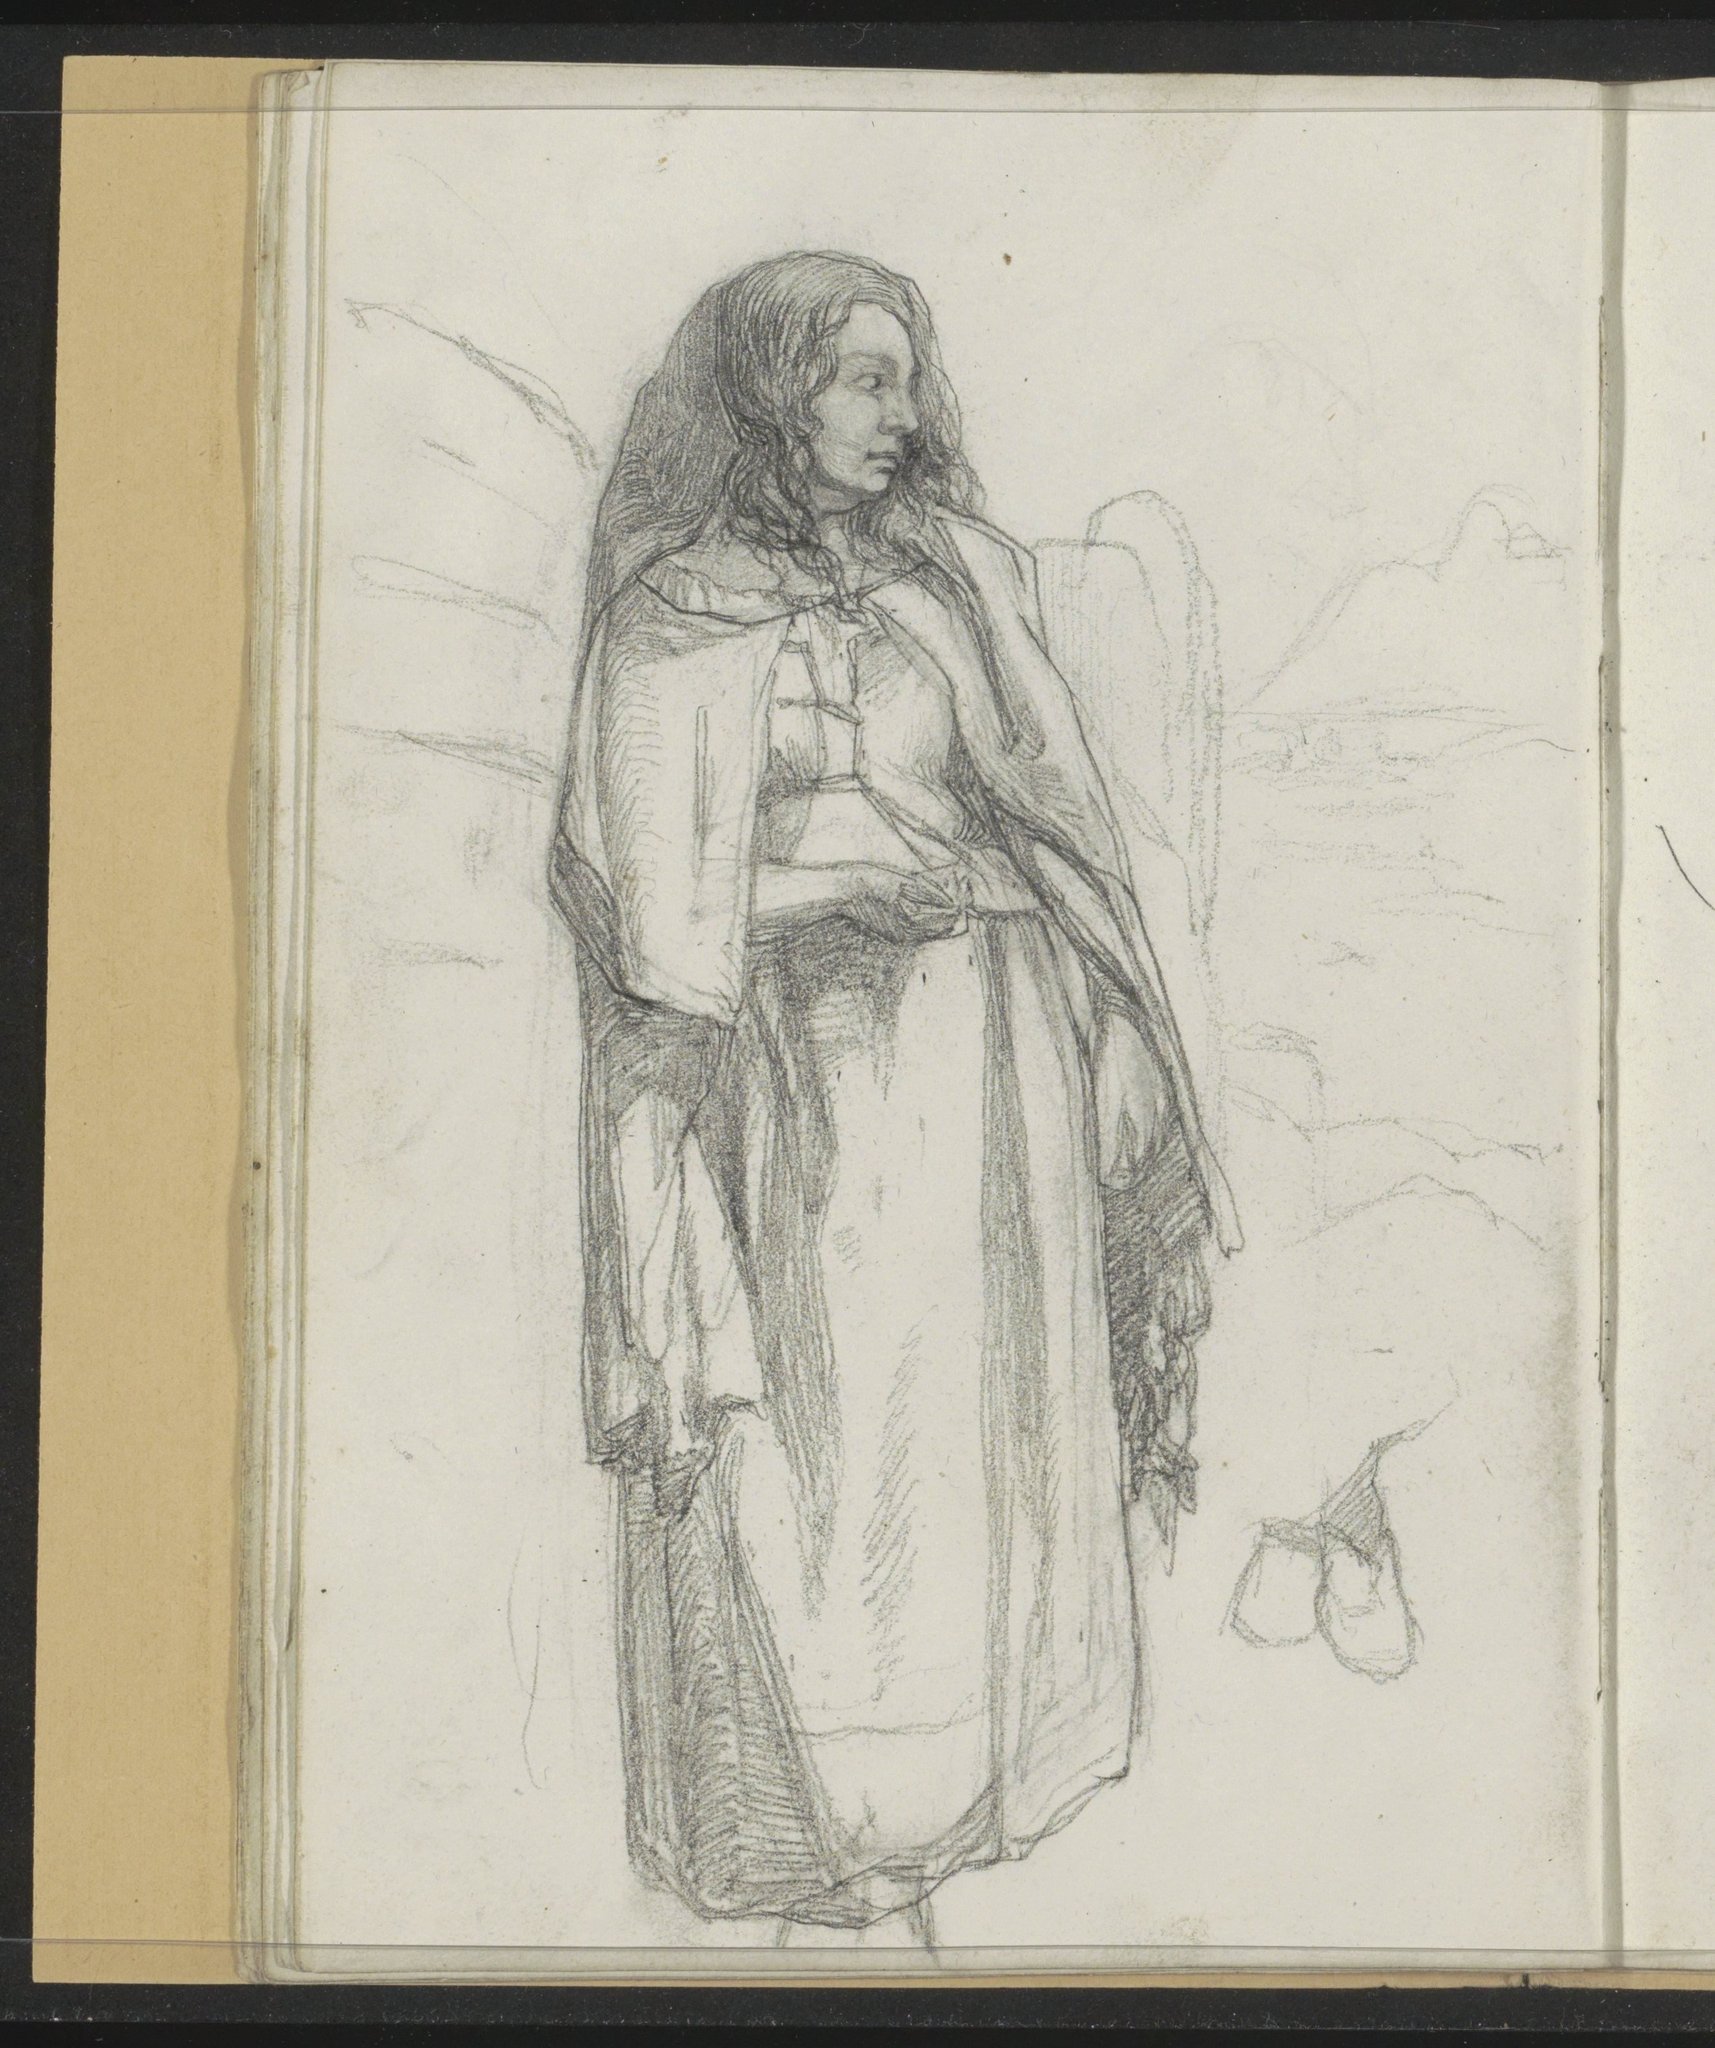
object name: sketchbook leaf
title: Staande vrouw met een cape in een berglandschap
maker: jozef israëls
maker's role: draughtsman, painter, print maker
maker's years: 1824-1911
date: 1834-1911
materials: paper, pencil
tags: cape (+ women's clothes), standing figure - aa - female human figure (+ adult female (human being)), mountains (+ landscape with figures, staffage)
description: De vrouw draagt een hoofddoek over haar lange haren. Op de achtergrond zijn rotsachtige bergen te zien. Blad 11 verso uit een schetsboek met 16 bladen.